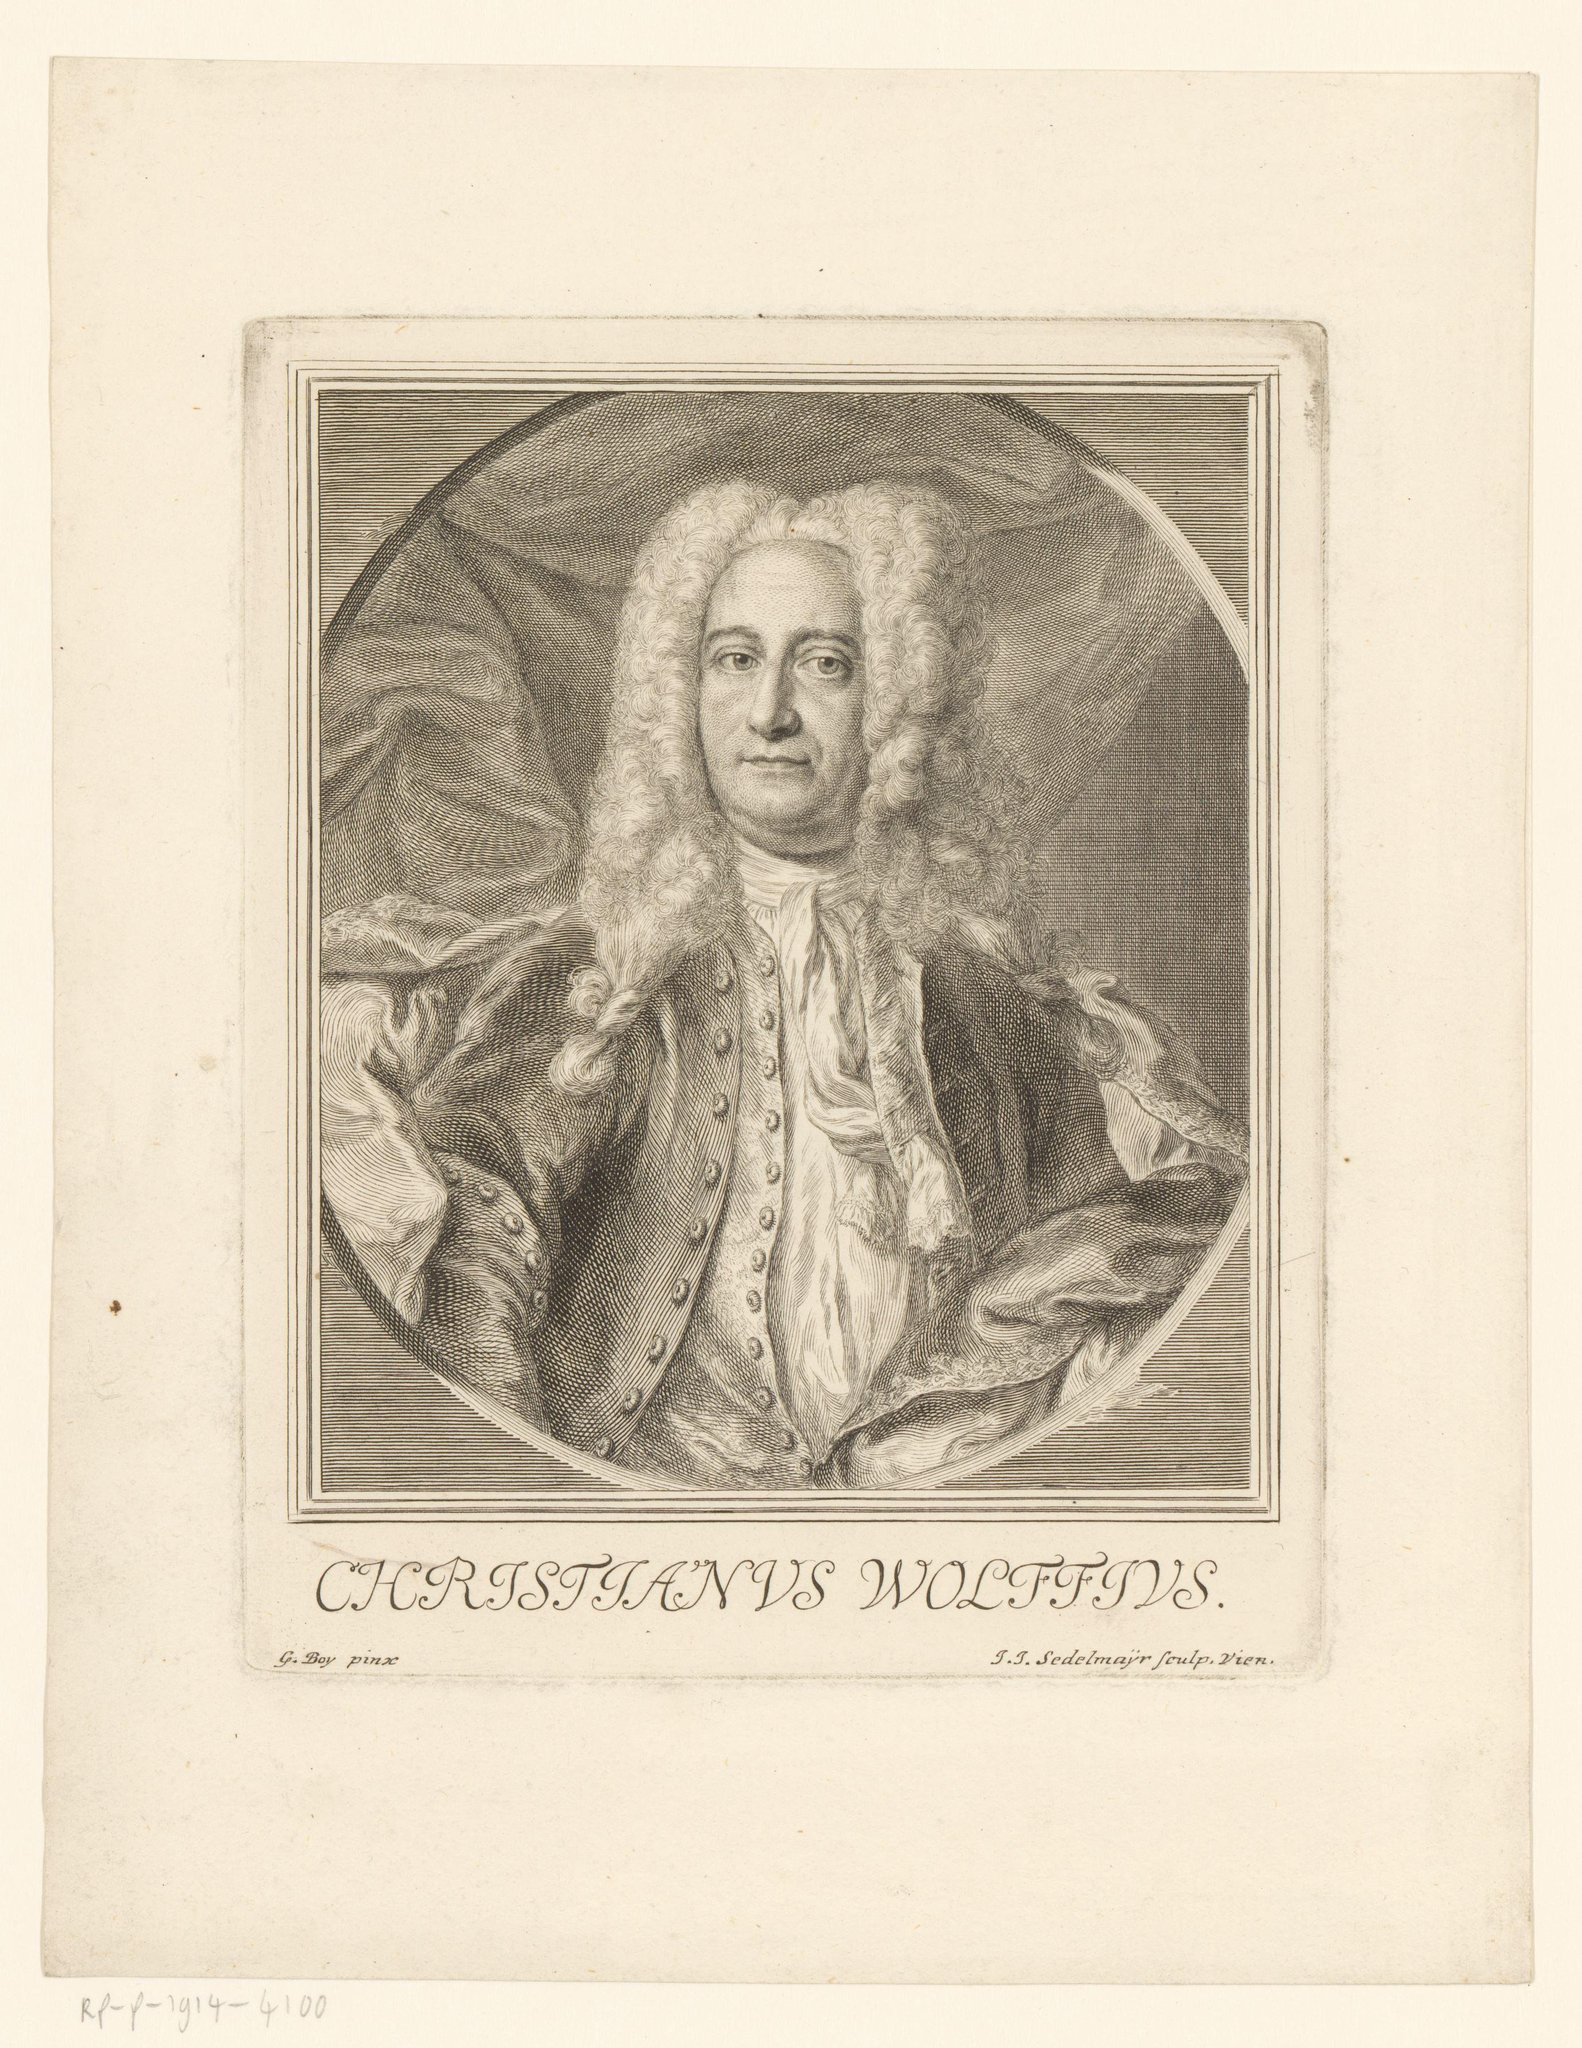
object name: print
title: Portret van Christi Wolff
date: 1716-1761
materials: paper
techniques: engraving, etching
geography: vienna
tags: historical persons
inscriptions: collector's mark: Lugt 2228